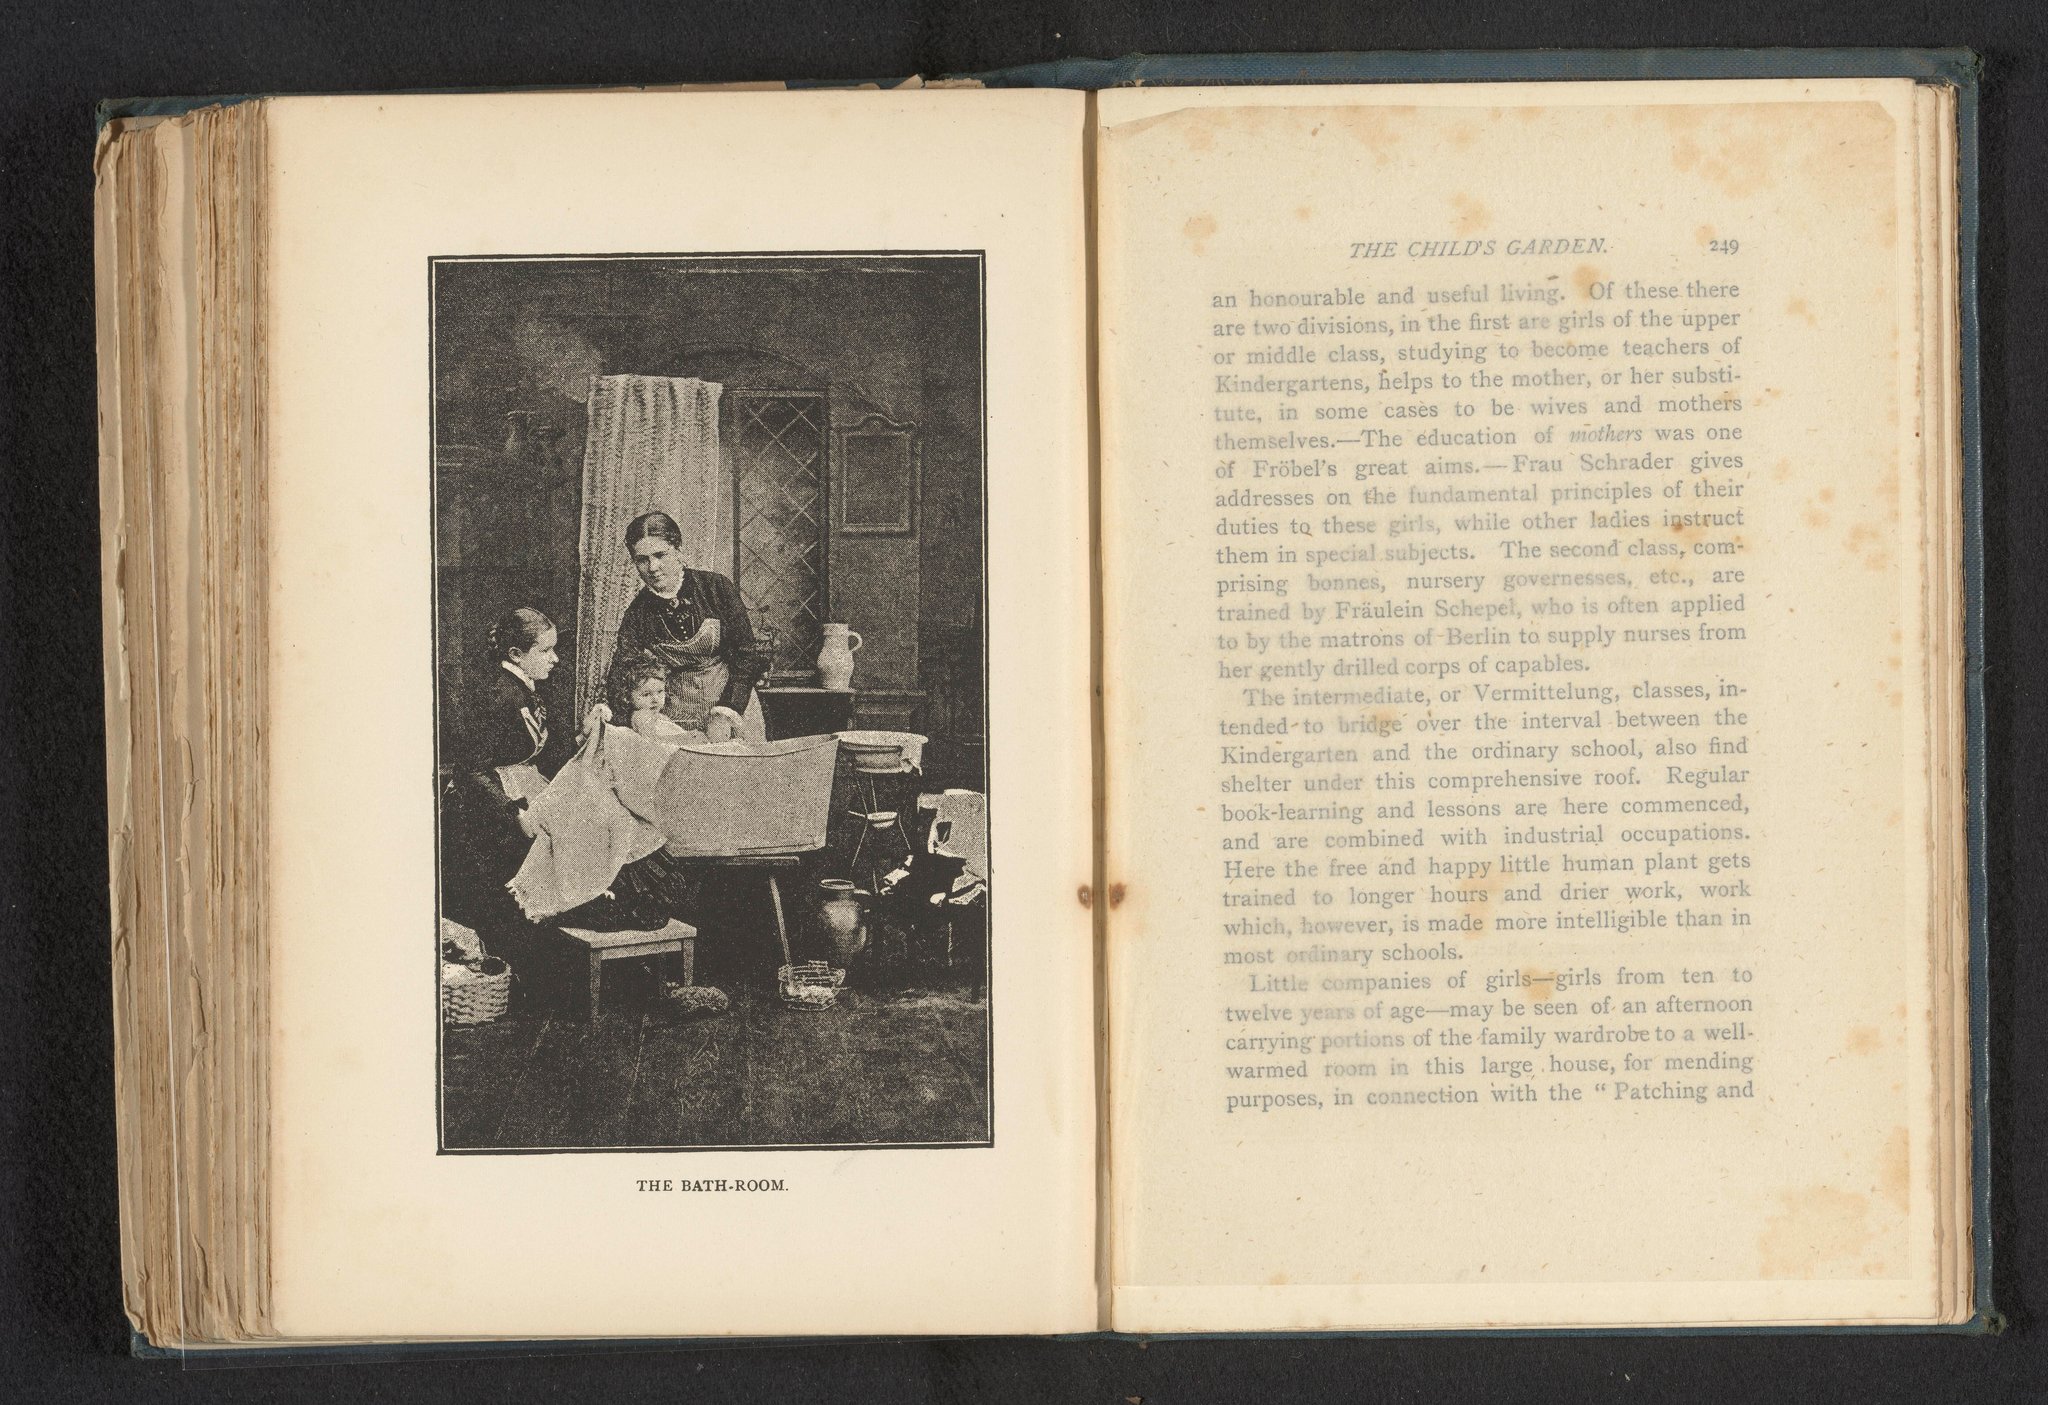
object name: page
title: The bath-room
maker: Anonymous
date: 1883-1888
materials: paper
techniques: autotype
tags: royal children, interior ~ representation of a building, bath-tub